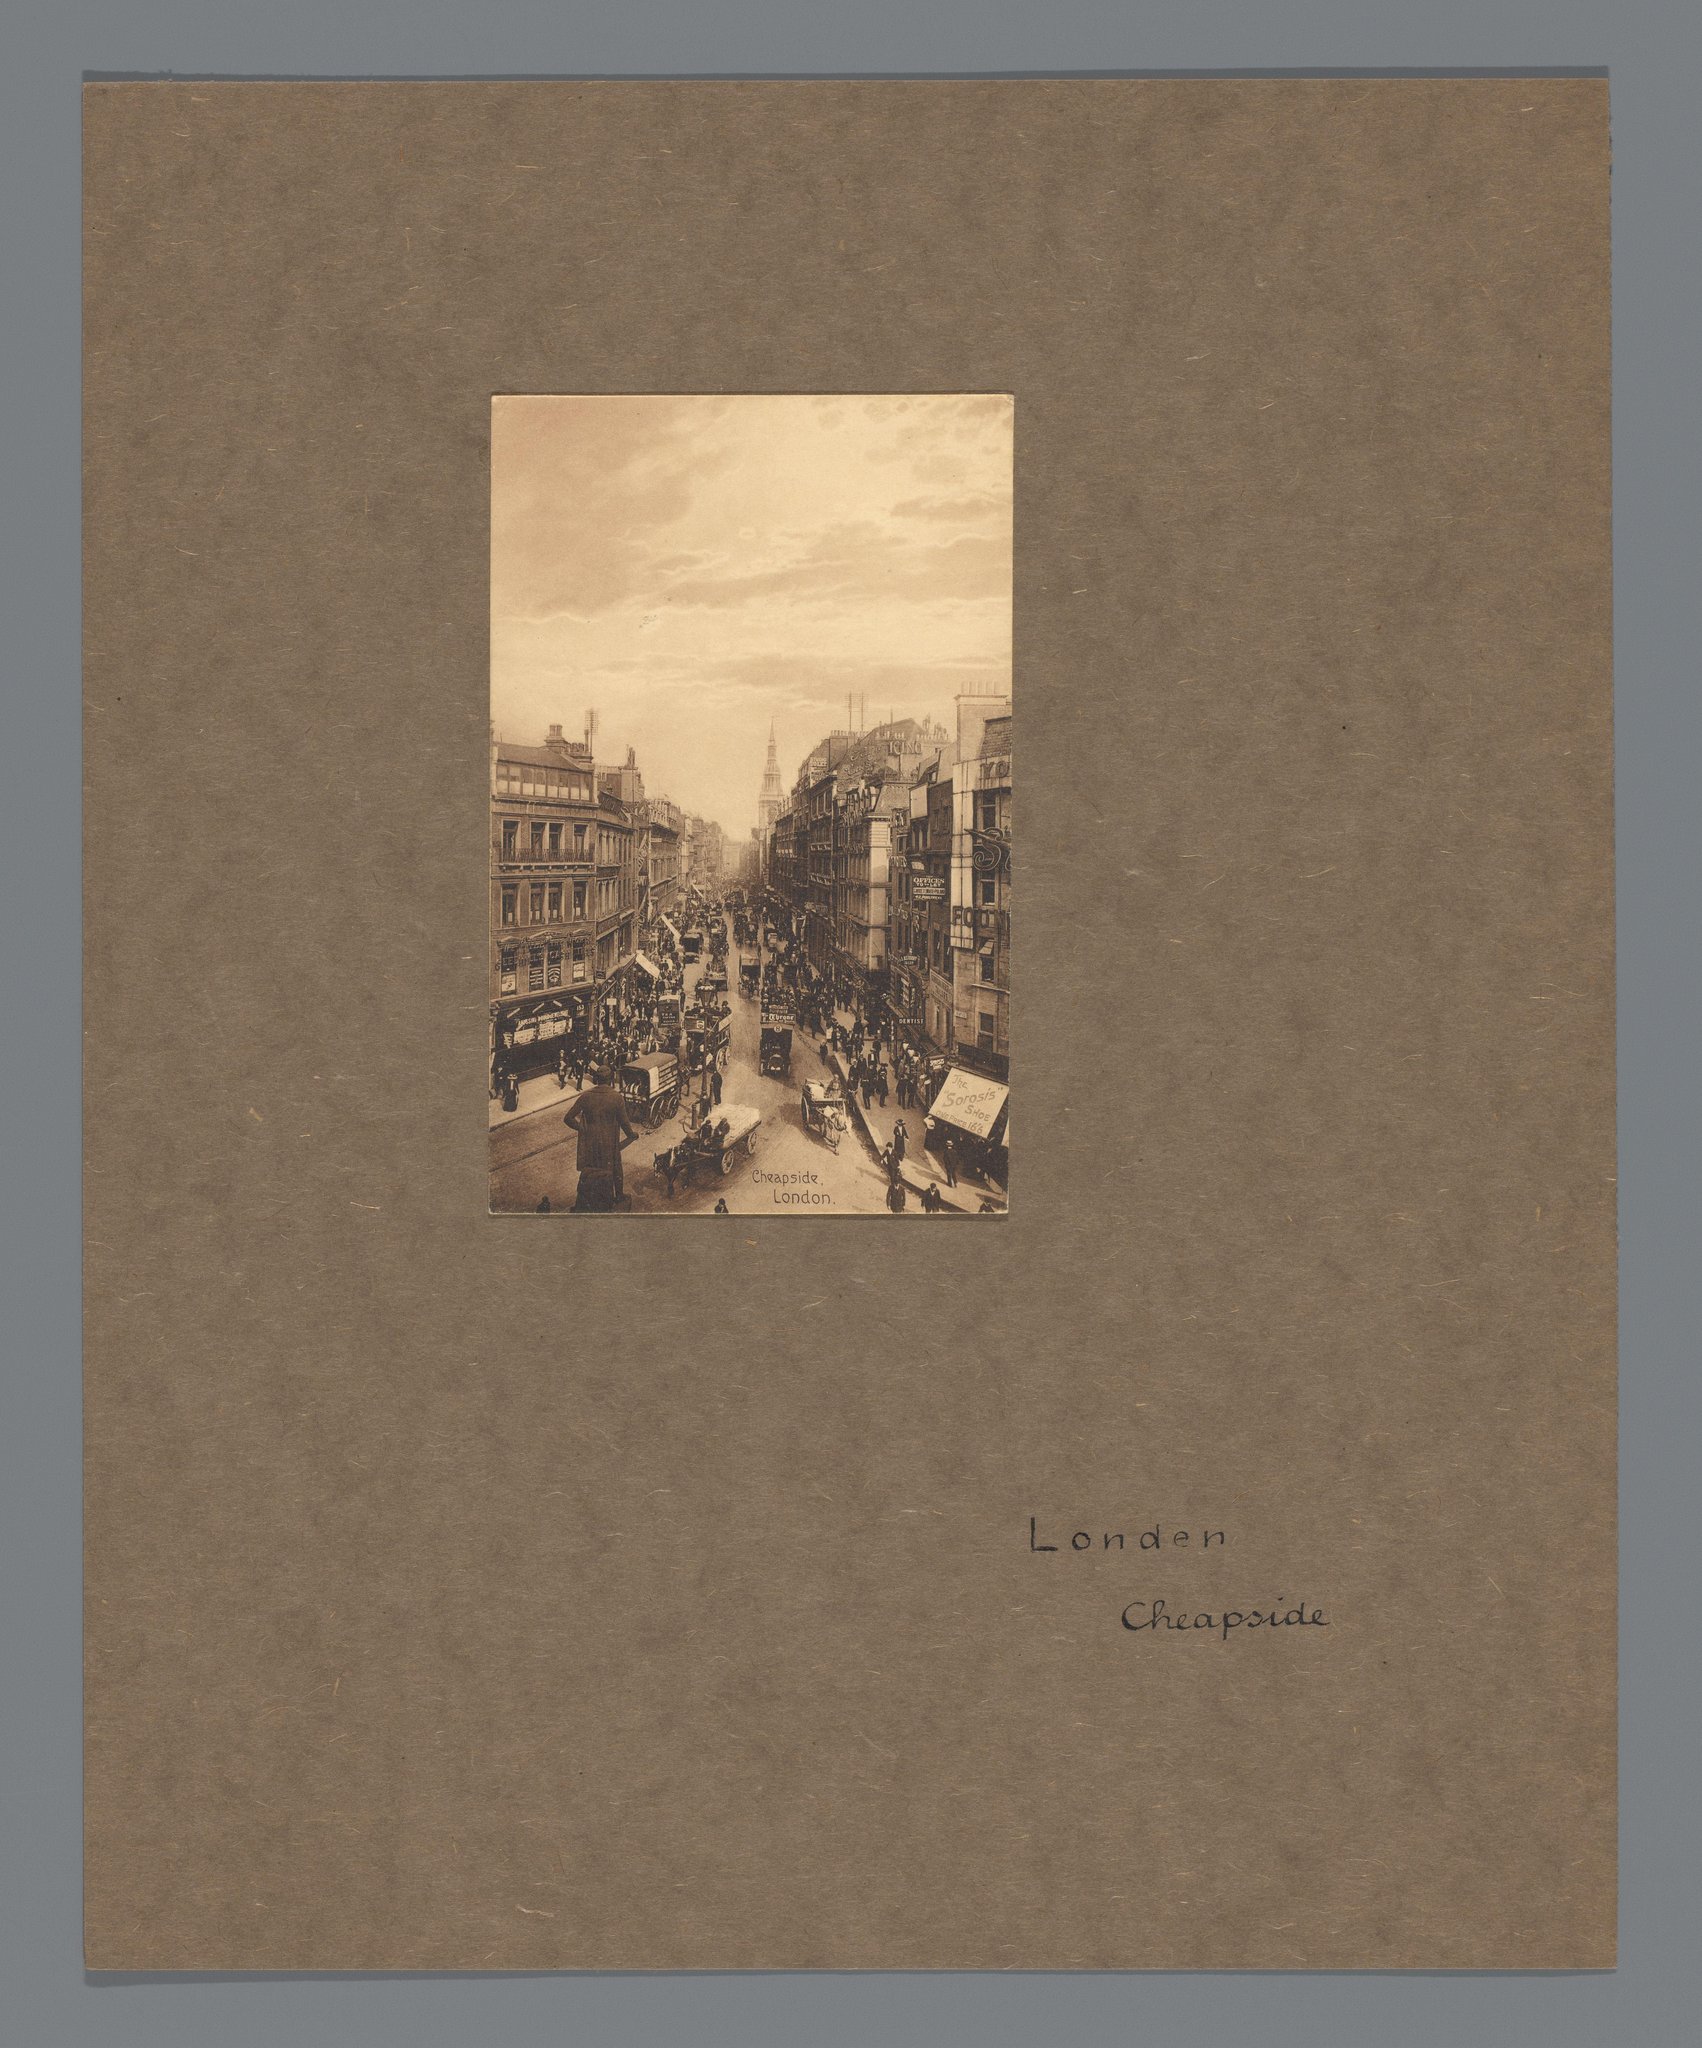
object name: photograph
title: Londen. Cheapside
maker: Anonymous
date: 1860-1925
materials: photographic support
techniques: photograph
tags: london